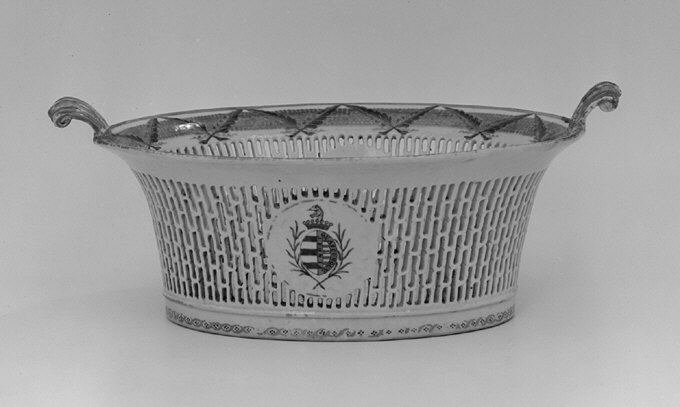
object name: fruit basket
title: Fruit basket (part of a service)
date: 1810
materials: hard paste porcelain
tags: coat of arms